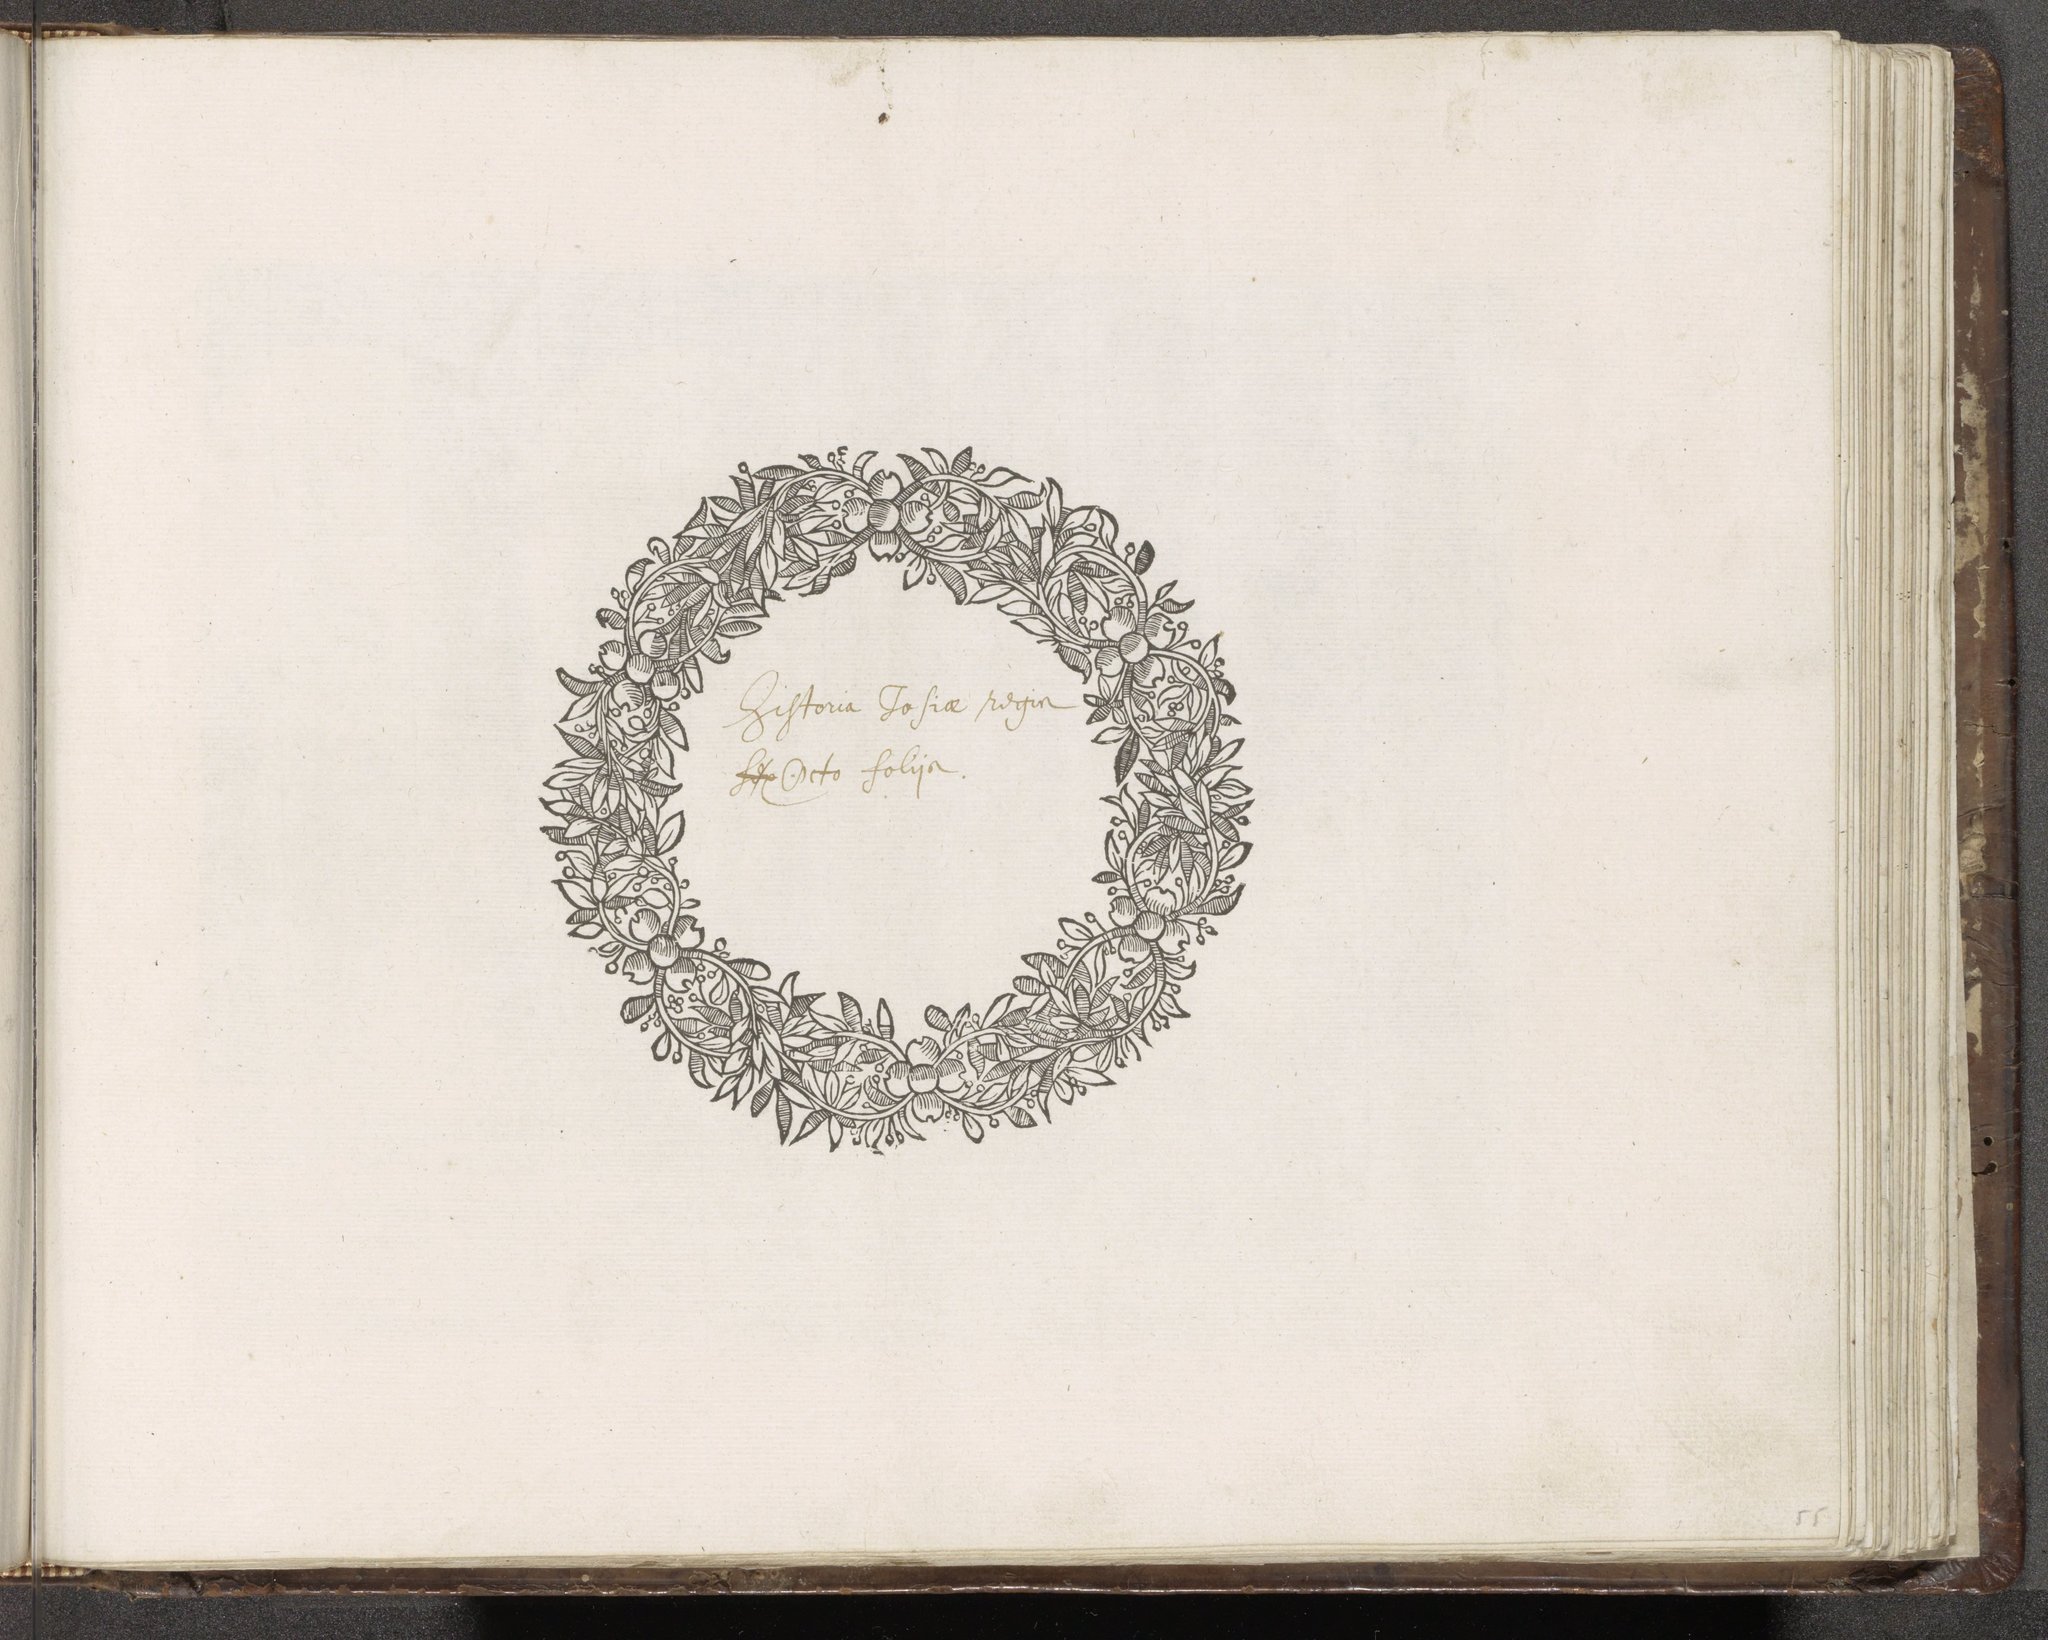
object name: print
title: Ornamentele bloemenkrans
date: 1579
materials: paper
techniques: woodcut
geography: antwerp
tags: garland, wreath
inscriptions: inscription: ‘Historia Josiae regin Octo folijn’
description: Ornamentele bloemenkrans met in het midden een handgeschreven titel. Prent maakt deel uit van een album.